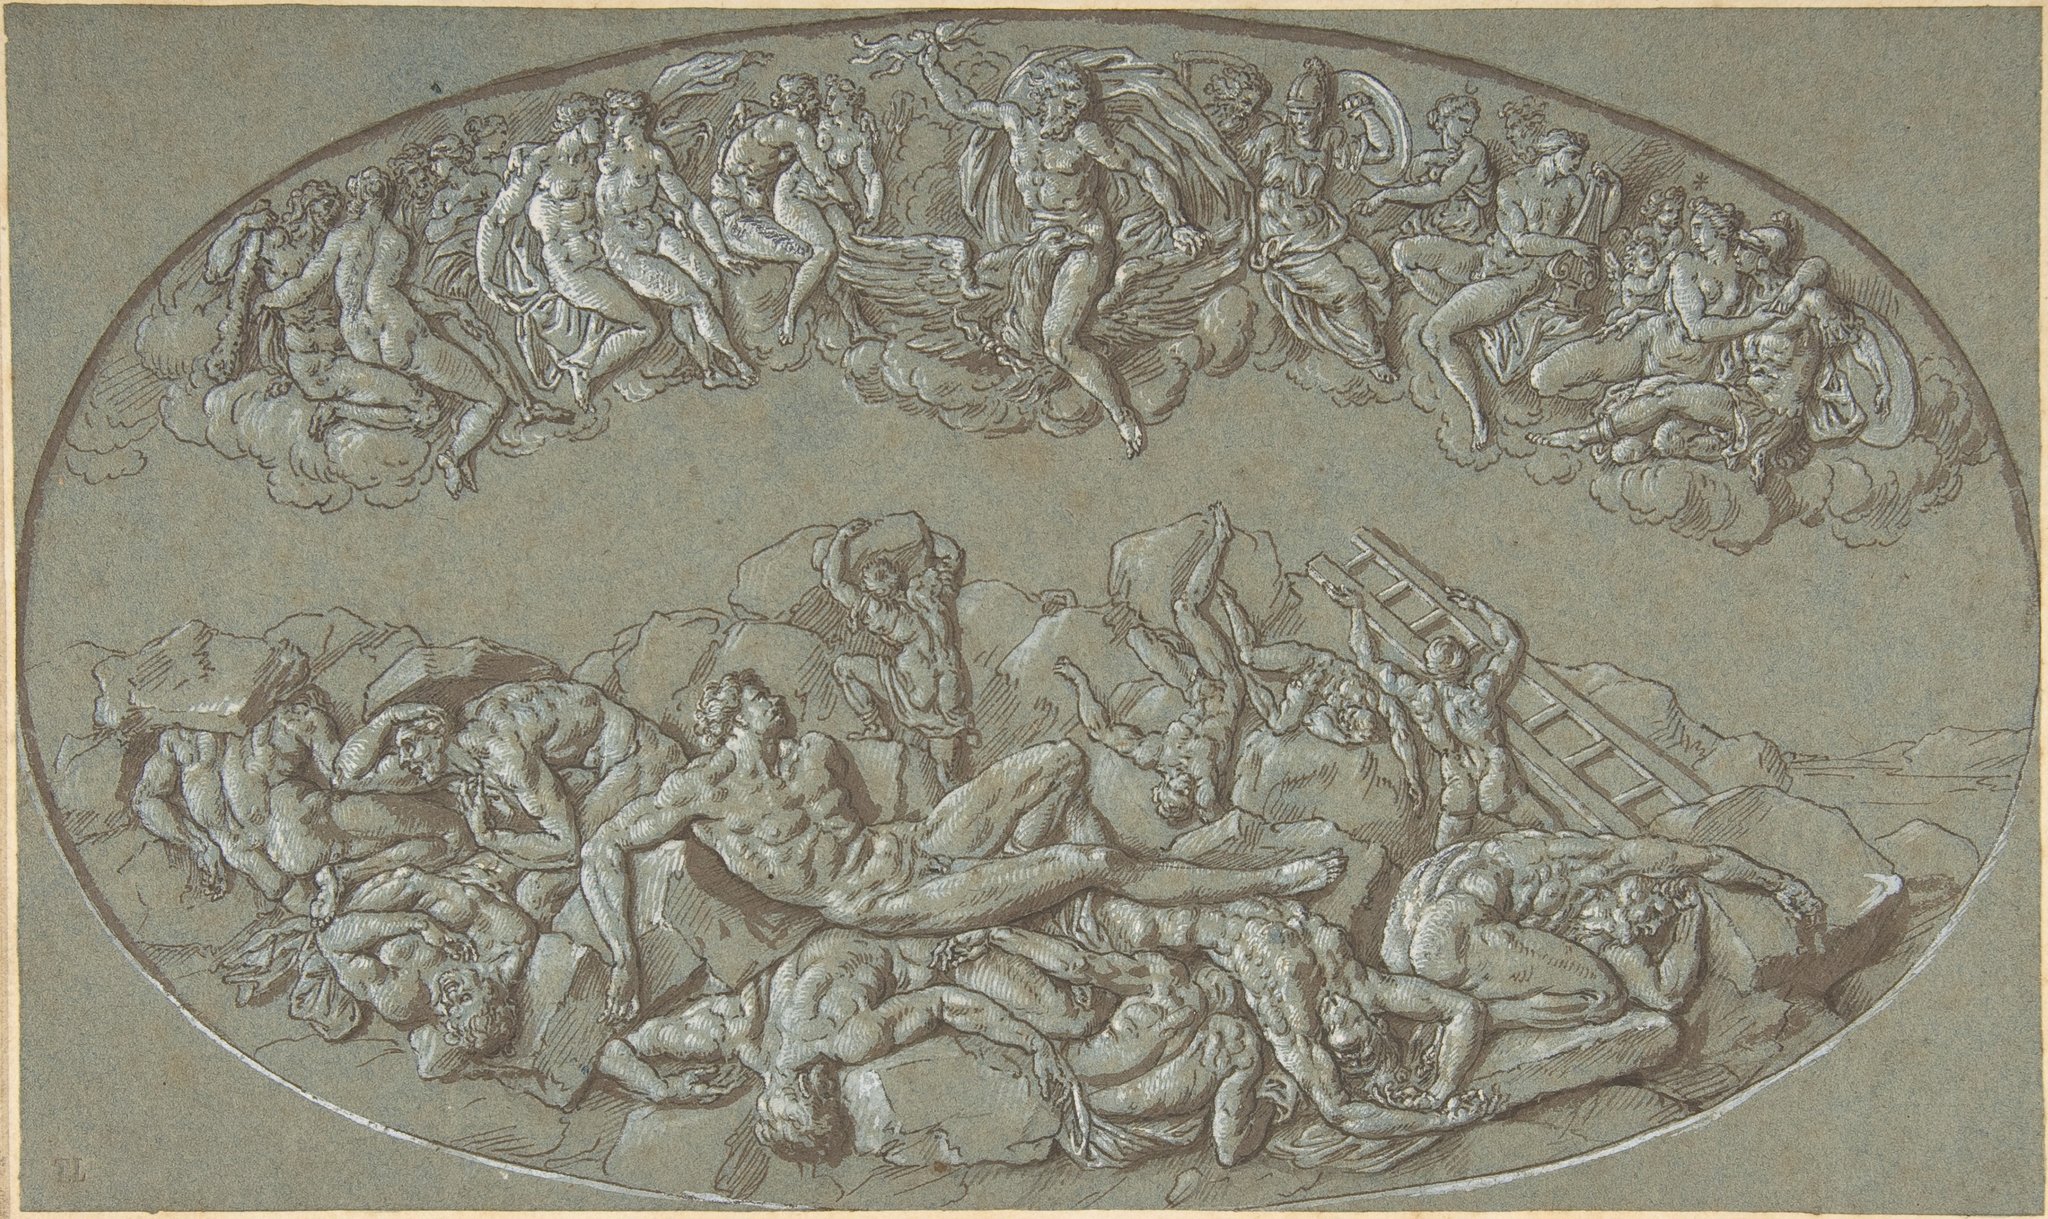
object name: drawing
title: Fall of the Giants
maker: bernard picart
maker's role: artist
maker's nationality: french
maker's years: 1673-1733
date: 1667-1733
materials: ink, paper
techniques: heightening, pen, wash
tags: male nudes,female nudes